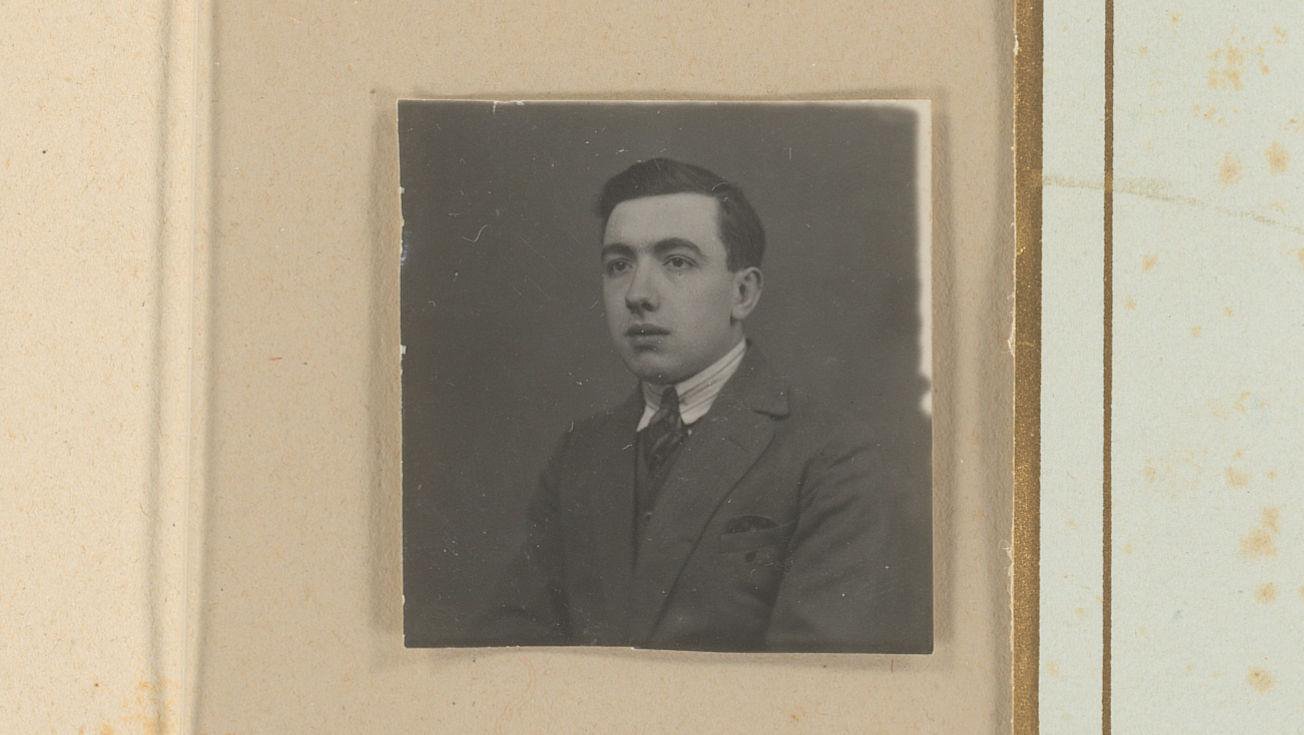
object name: photograph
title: Portret van een man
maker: Anonymous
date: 1900-1940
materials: photographic support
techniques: gelatin silver print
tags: historical persons